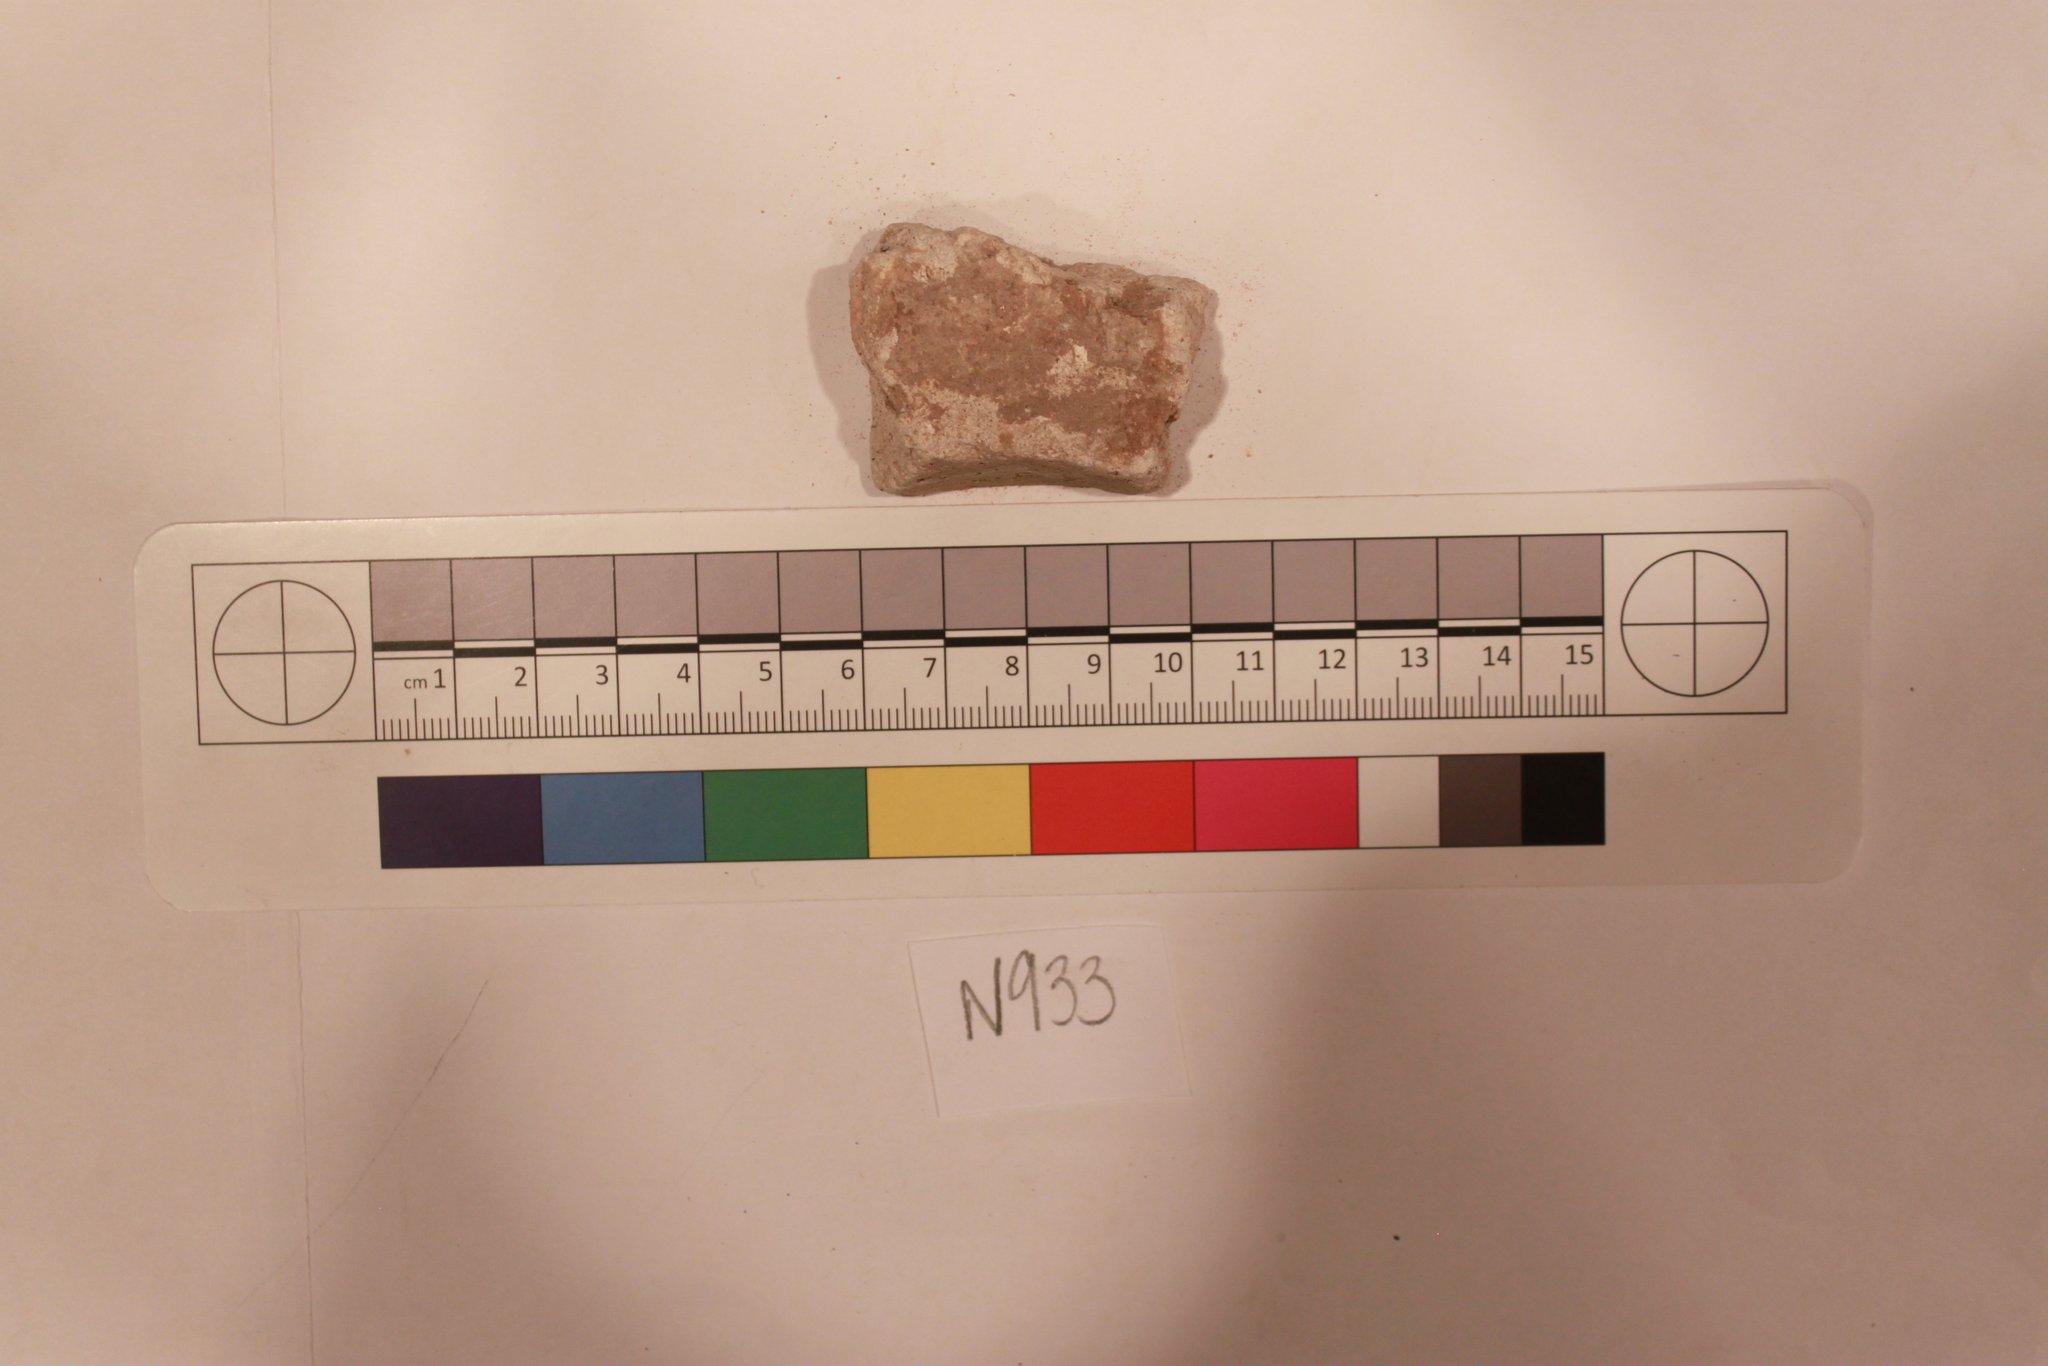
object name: fragment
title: Stucco Fragment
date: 701-1200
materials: plaster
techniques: carving, painting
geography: iran